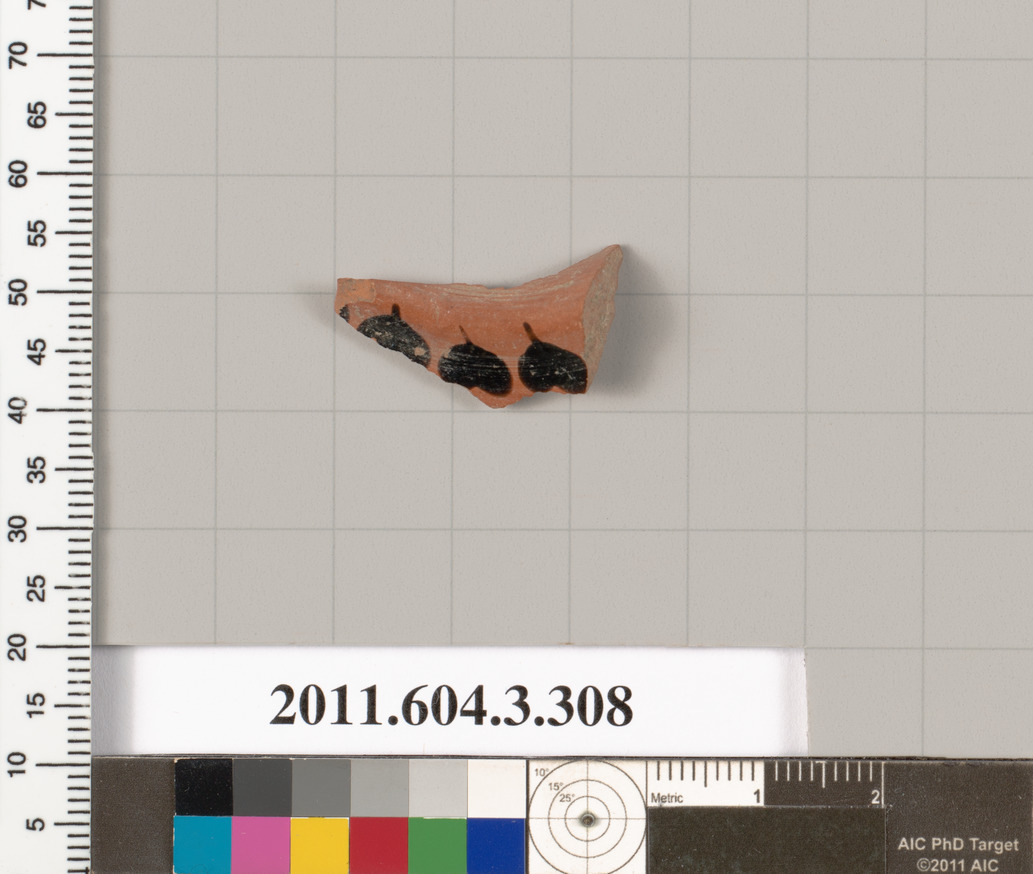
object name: neck amphora fragment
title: Terracotta fragment of a neck-amphora (jar)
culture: greek, attic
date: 550-501 BCE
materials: terracotta